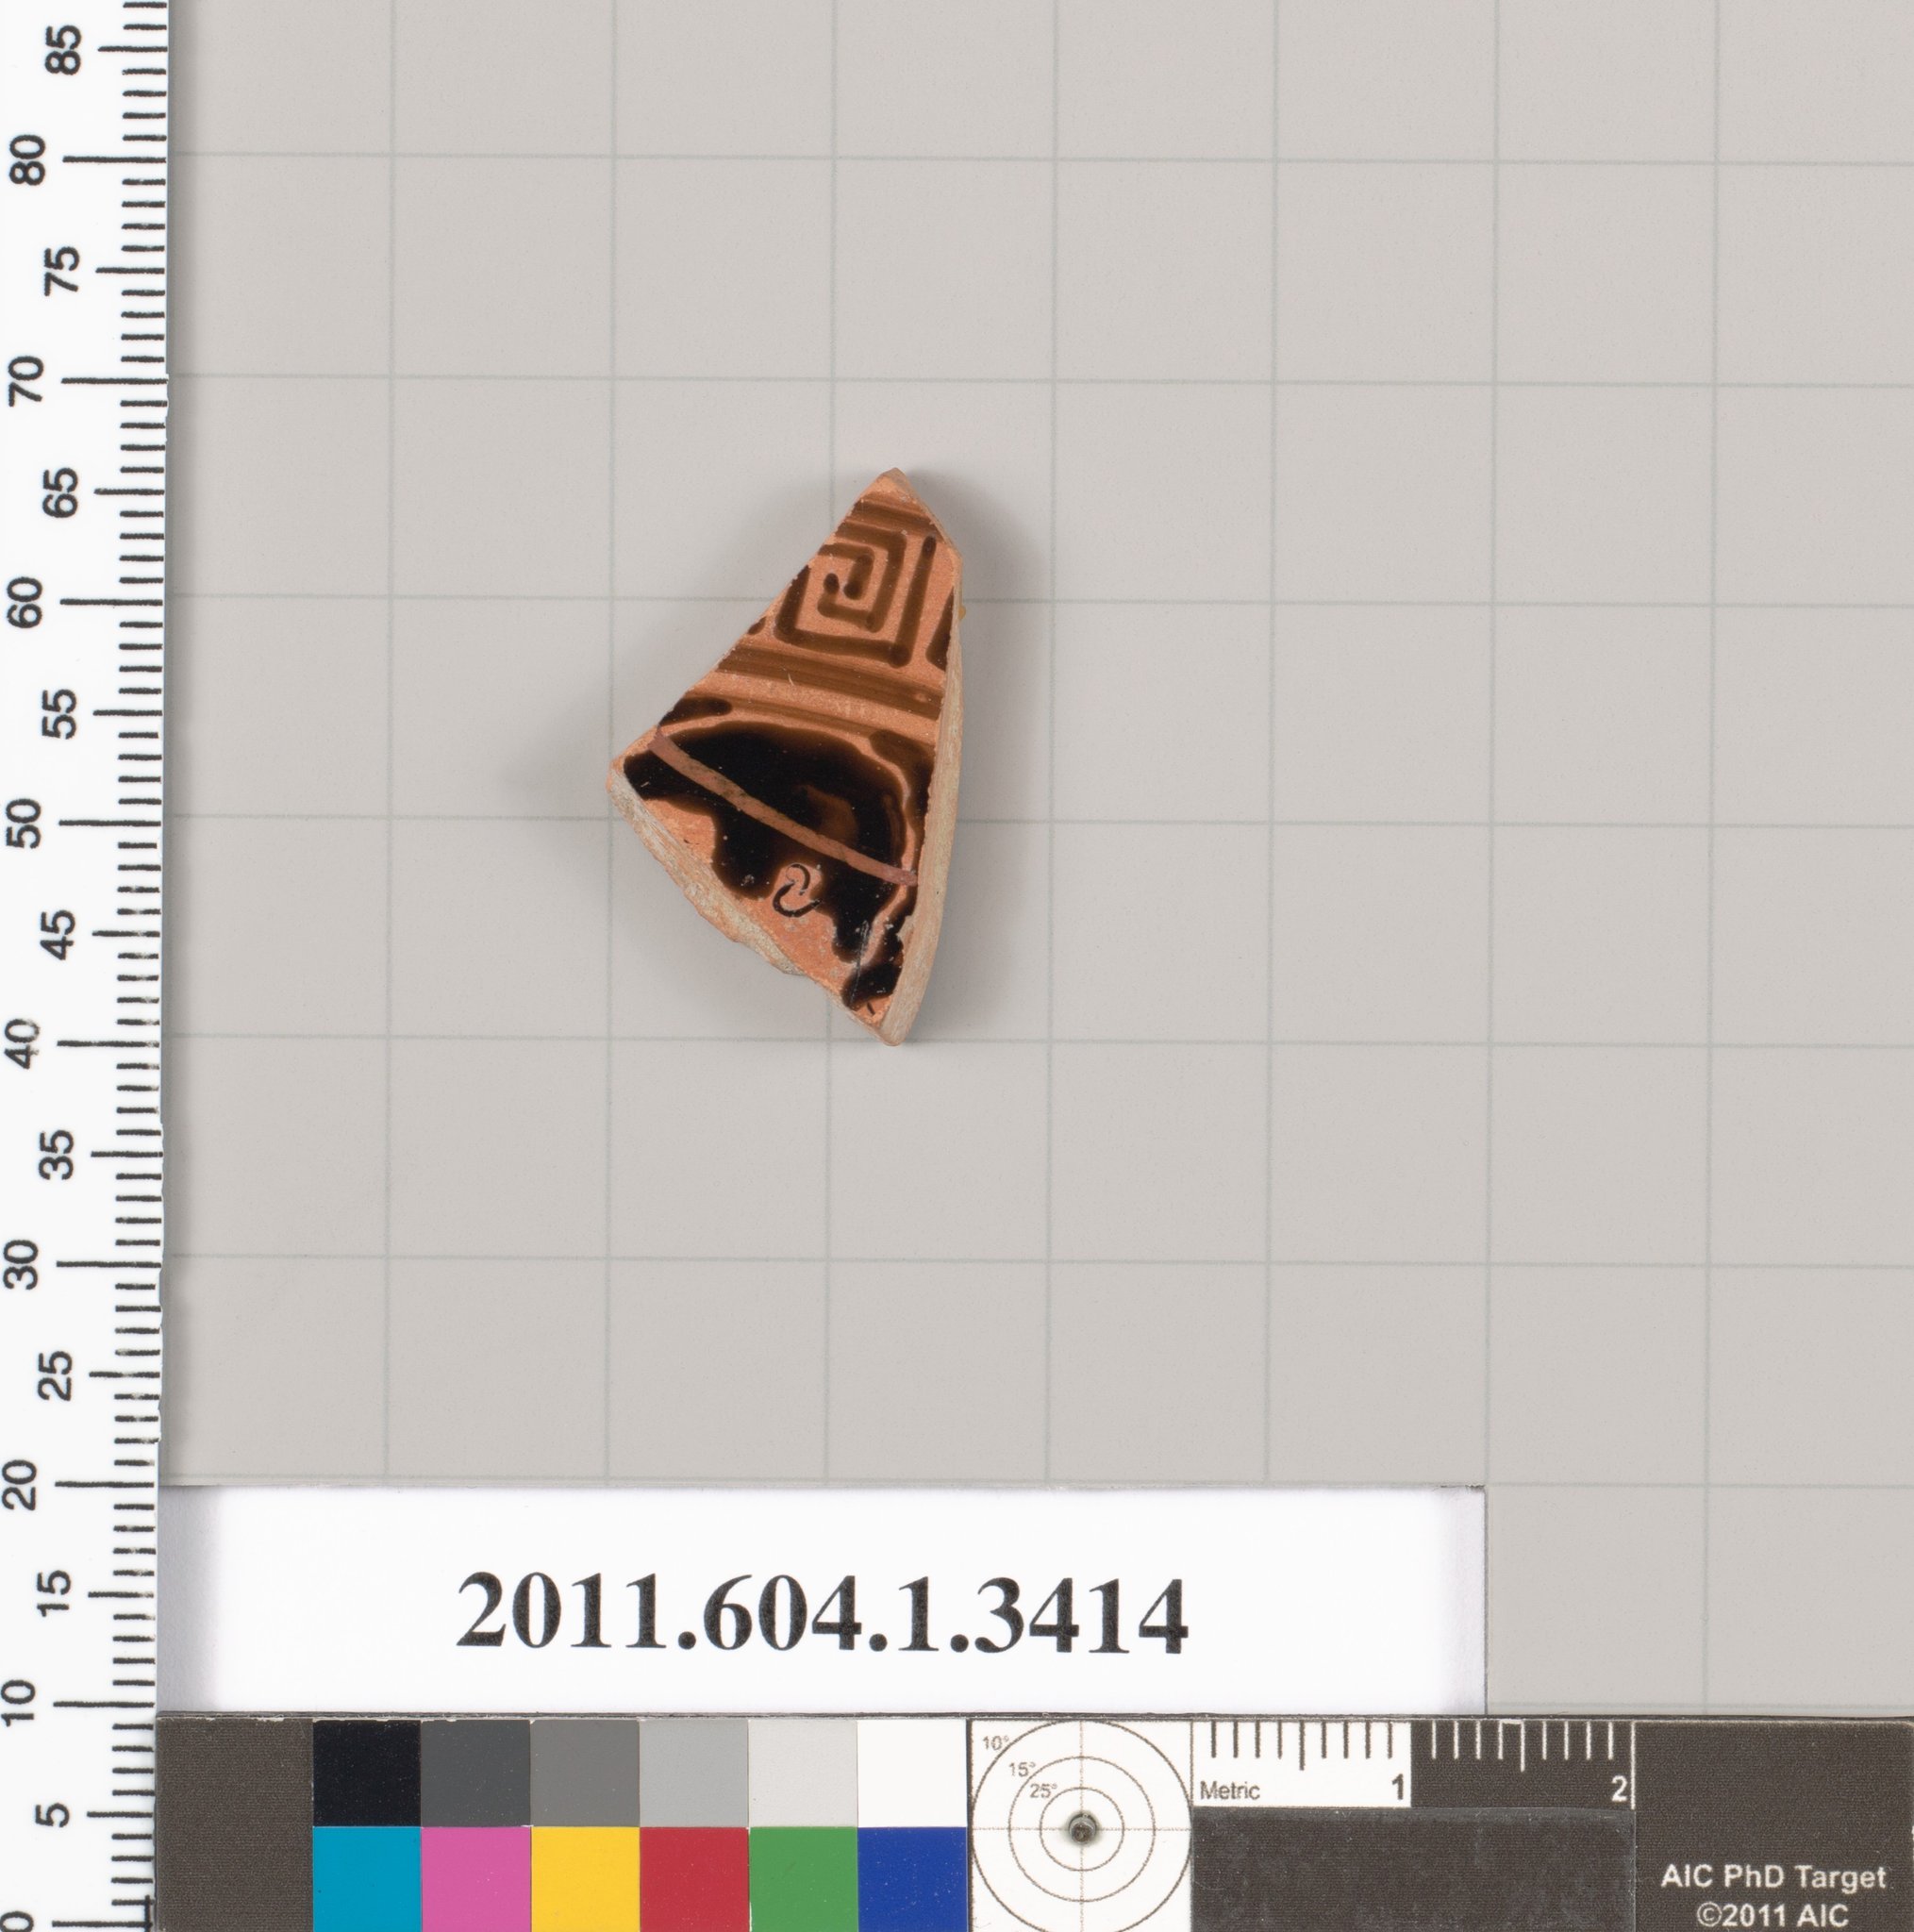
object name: kylix fragment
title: Terracotta fragment of a kylix (drinking cup)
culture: greek, attic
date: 490-470 BCE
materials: terracotta